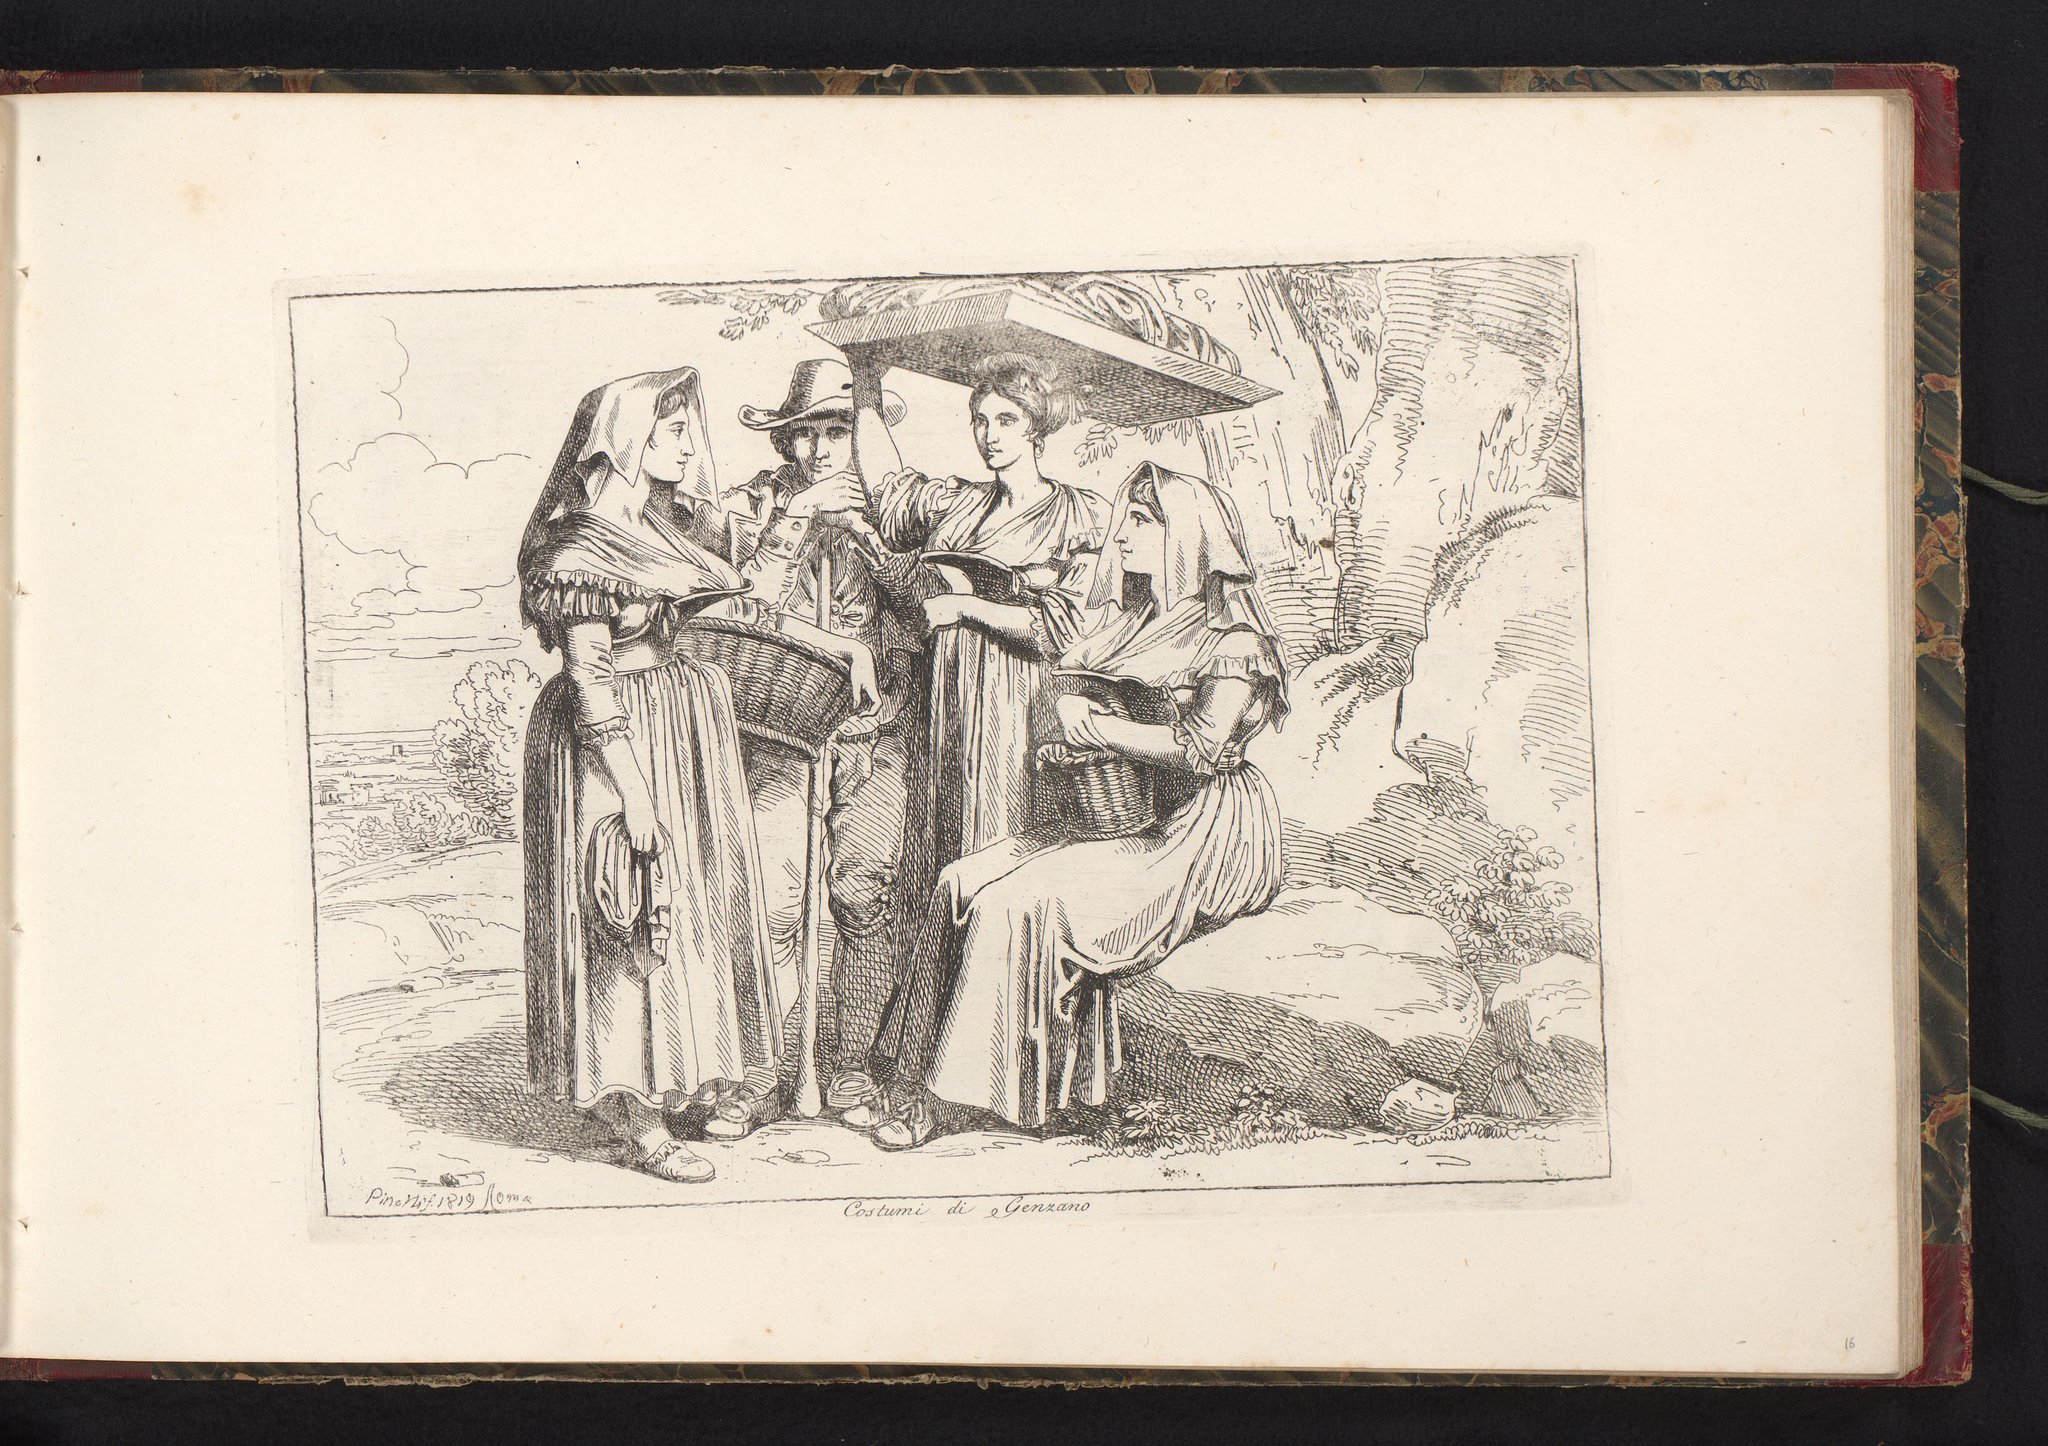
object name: print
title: Kostuumprenten met figuren uit Rome en omgeving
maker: bartolomeo pinelli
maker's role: draughtsman, print maker, sculptor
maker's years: 1781-1835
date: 1819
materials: paper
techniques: etching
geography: rome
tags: city-view, and landscape with man-made constructions, adolescent, young woman, maiden, herding, herdsman, herdswoman, shepherd, shepherdess, cowherd, etc., head-gear: hat, folk costume, regional costume, carrying something on the head or on the shoulders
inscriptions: date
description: Drie vrouwen en een herder in een landschap. Eén van de vrouwen draagt een groot blad op haar hoofd. De prent maakt deel uit van een album.